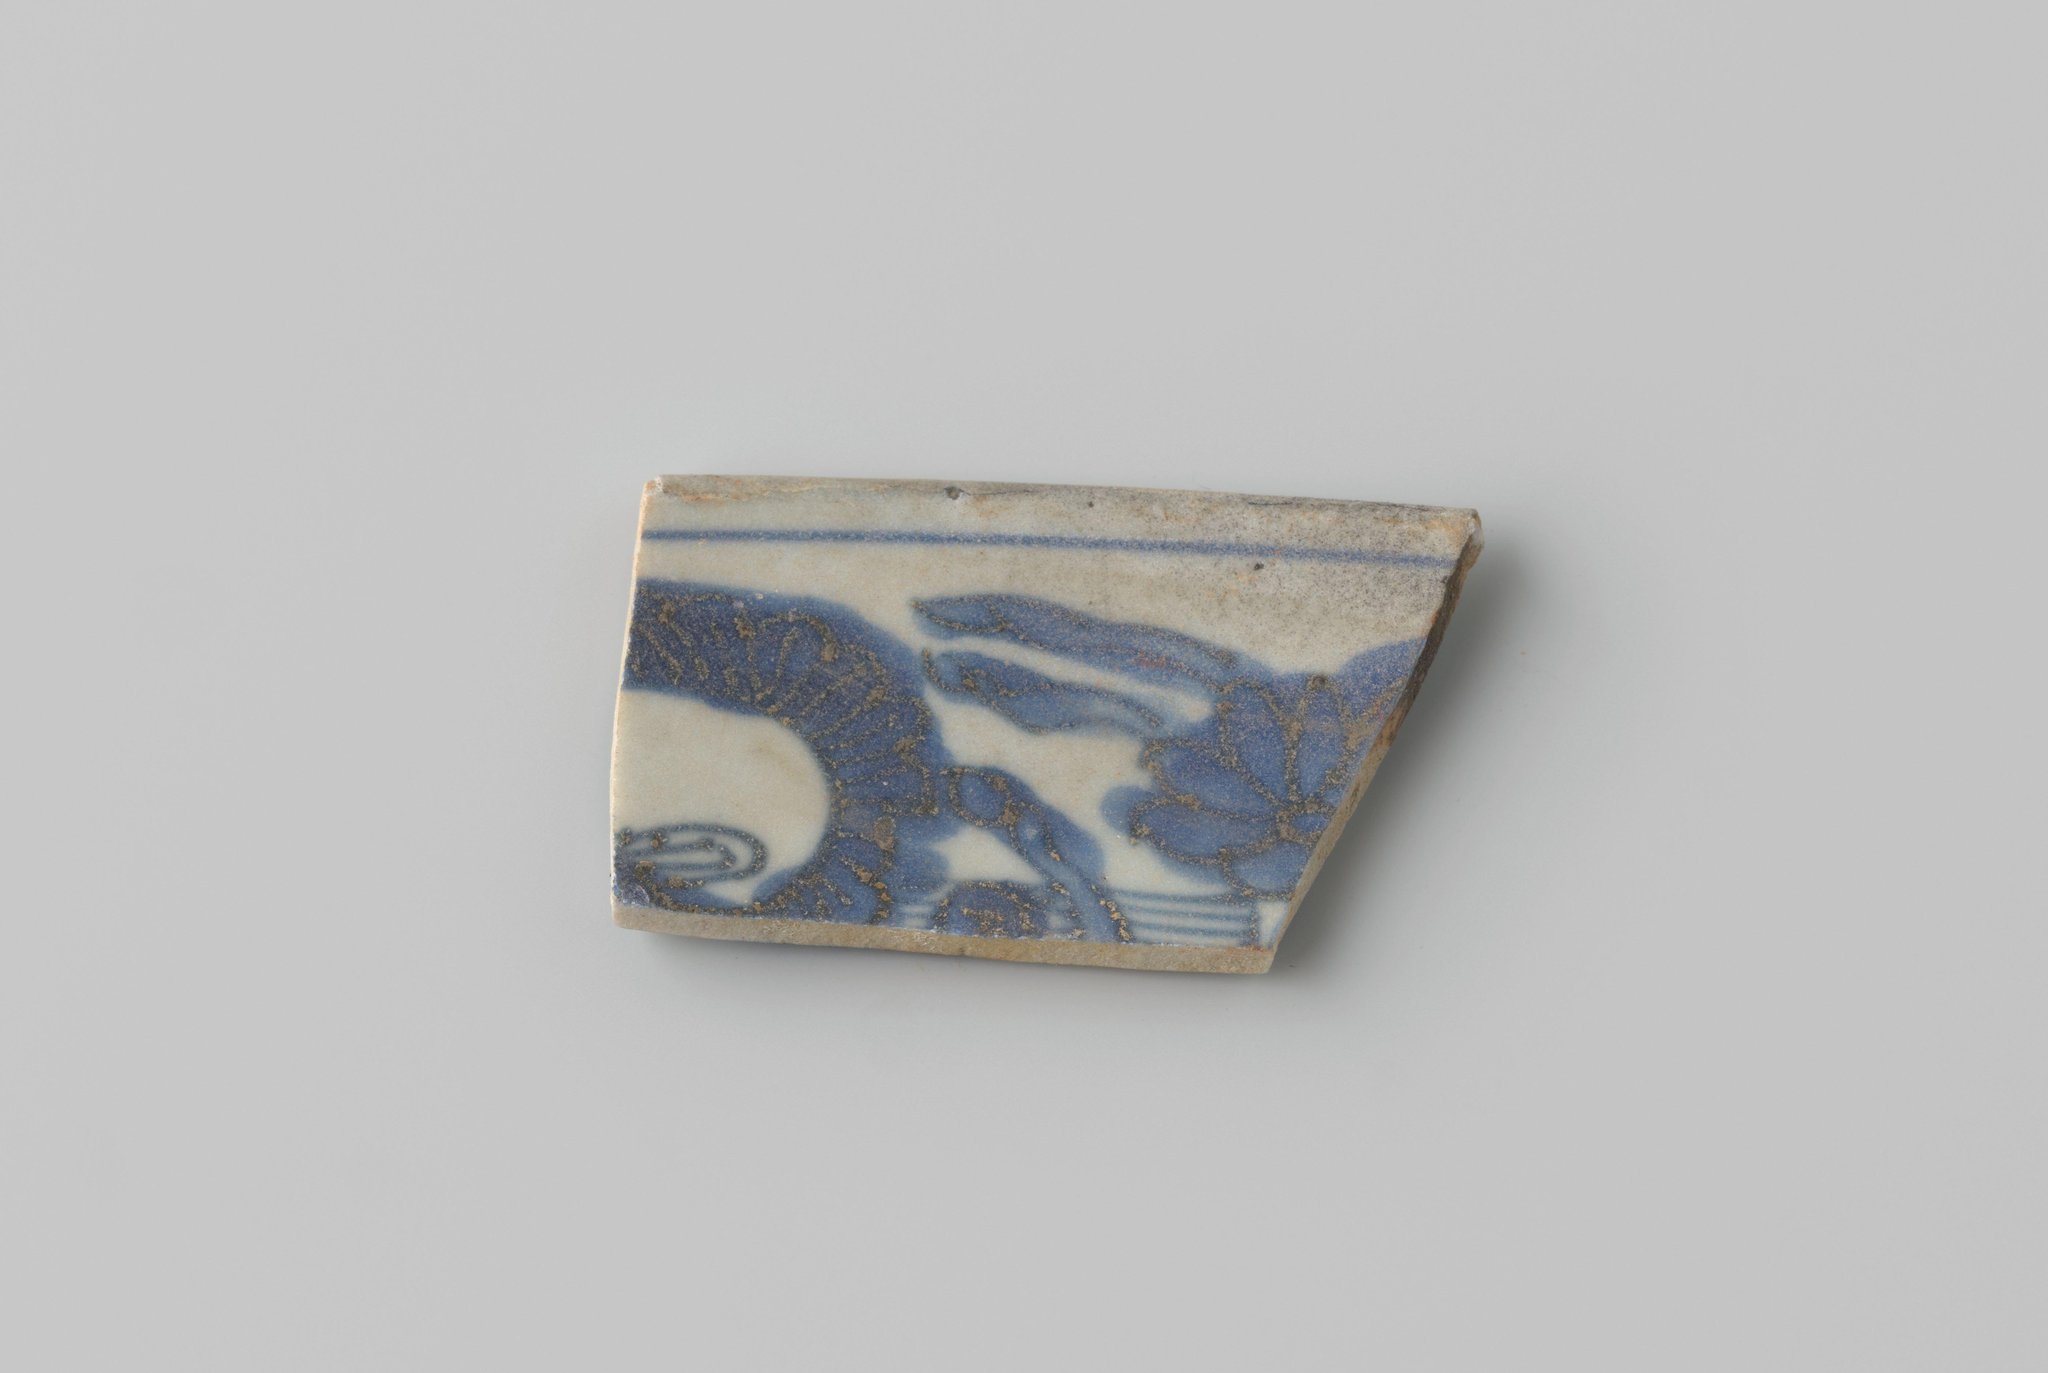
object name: sherd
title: Scherf van een bord uit V.O.C.-schip de 'Witte Leeuw'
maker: Anonymous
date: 1613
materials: porcelain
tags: verenigde oostindische compagnie, sint-helena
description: Scherf van een bord uit V.O.C.-schip de 'Witte Leeuw'.